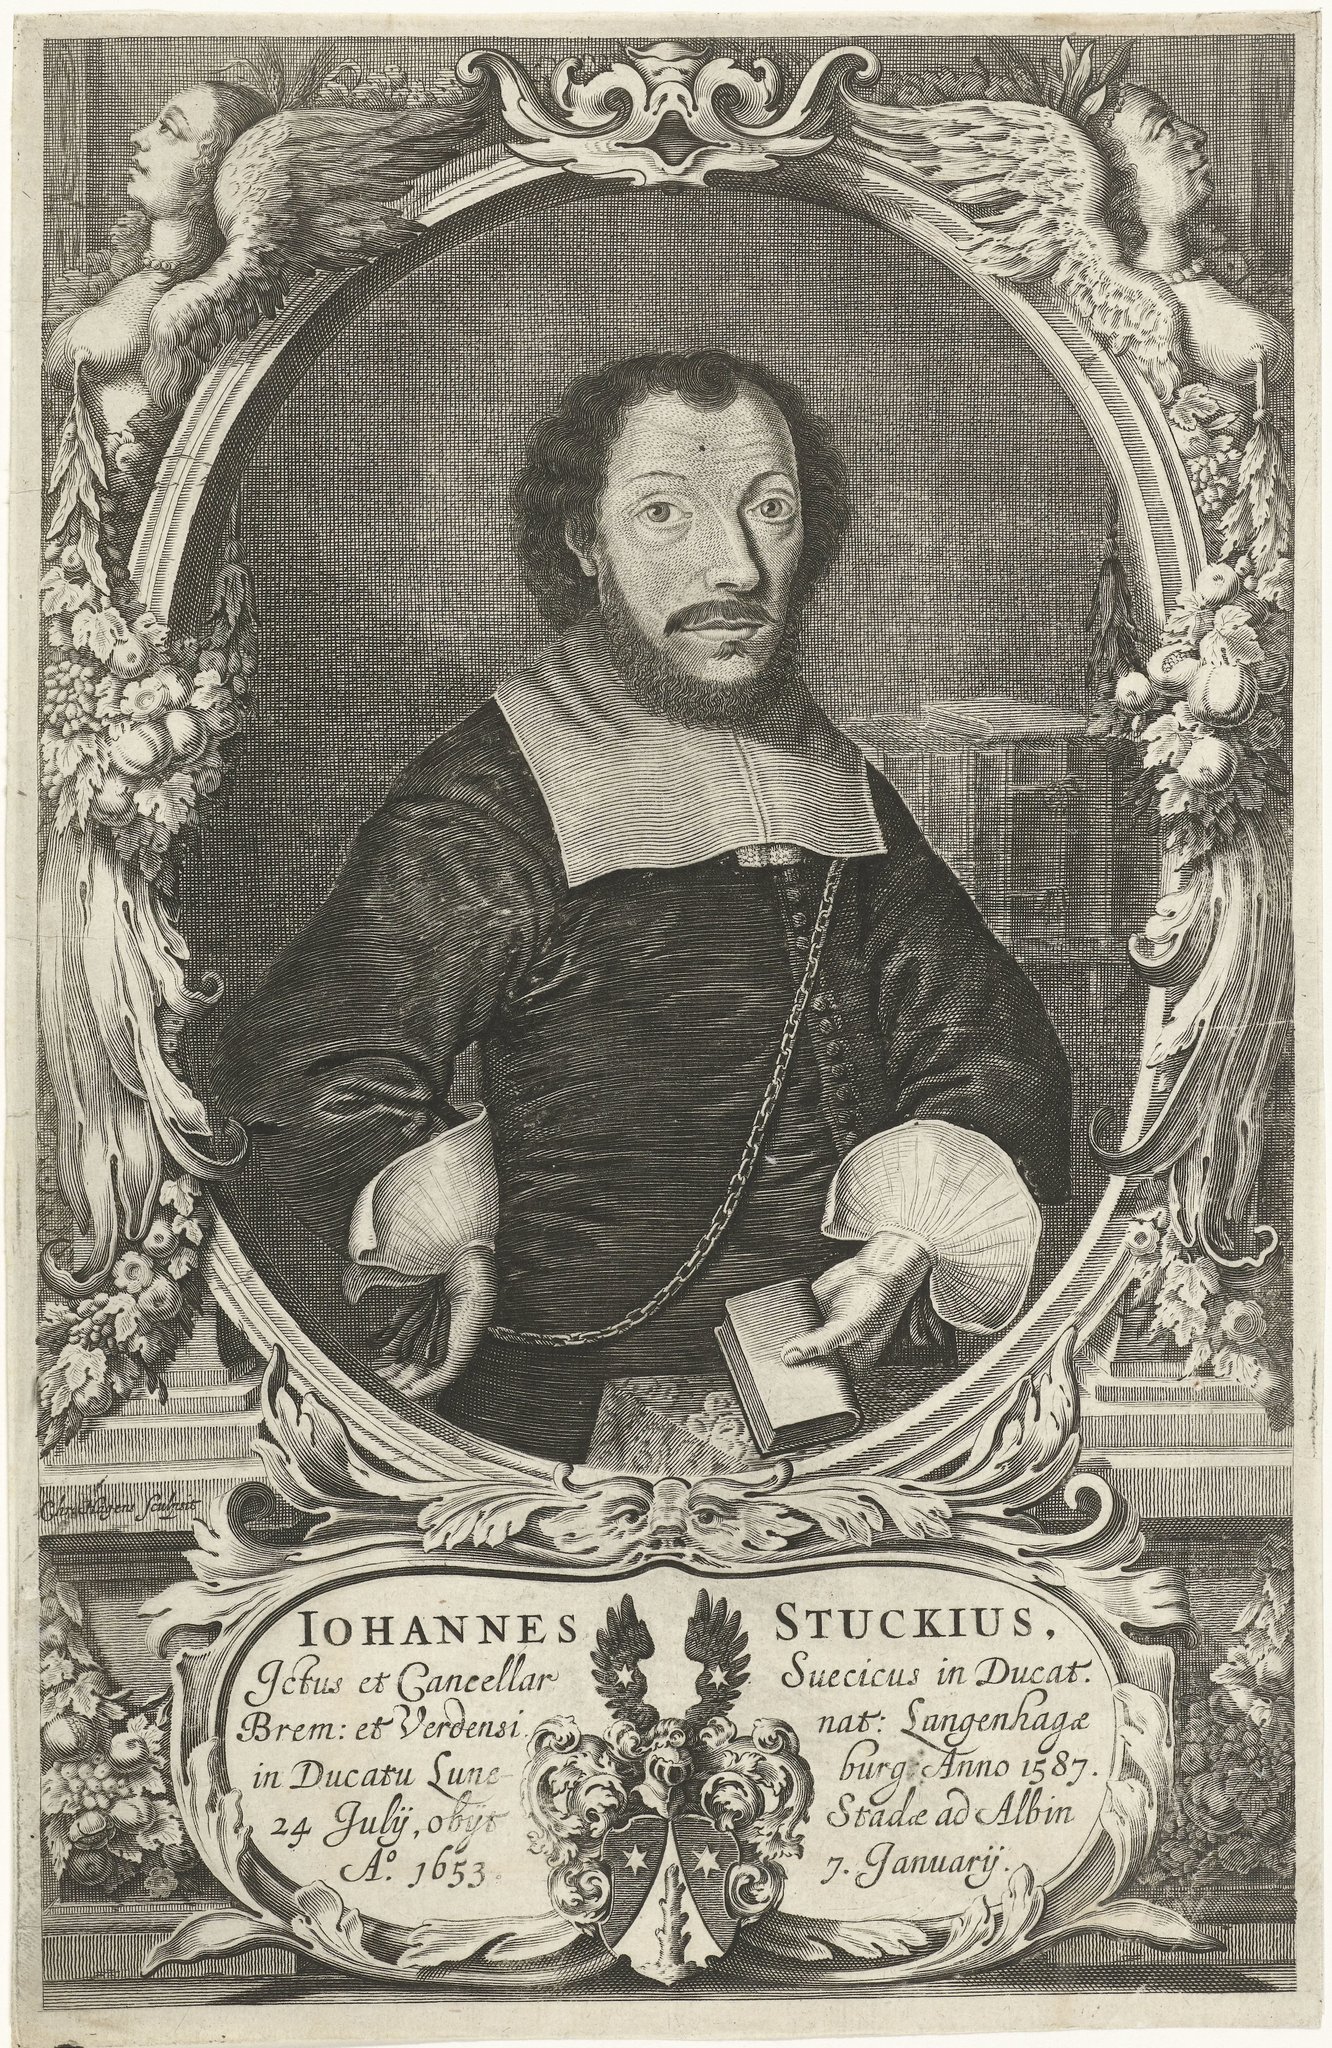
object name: print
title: Portret van Johannes Stuckius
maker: christiaan hagen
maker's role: draughtsman, print maker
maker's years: 1635-1707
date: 1663-1695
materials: paper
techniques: engraving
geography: amsterdam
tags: book, ornament ~ festoon, garland, beard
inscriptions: collector's mark: Lugt 2228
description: Portret ten halven lijve naar rechts van Johannes Stuckius in een ovaal met guirlandes en twee gevleugelde hermen. In zijn rechterhand houdt hij een boek. Op de achtergrond een rij boeken en voor hem een deel van een tafel. Onder zijn portret een cartouche met een wapen, waarop zijn naam en een vijfregelige tekst in Latijn.